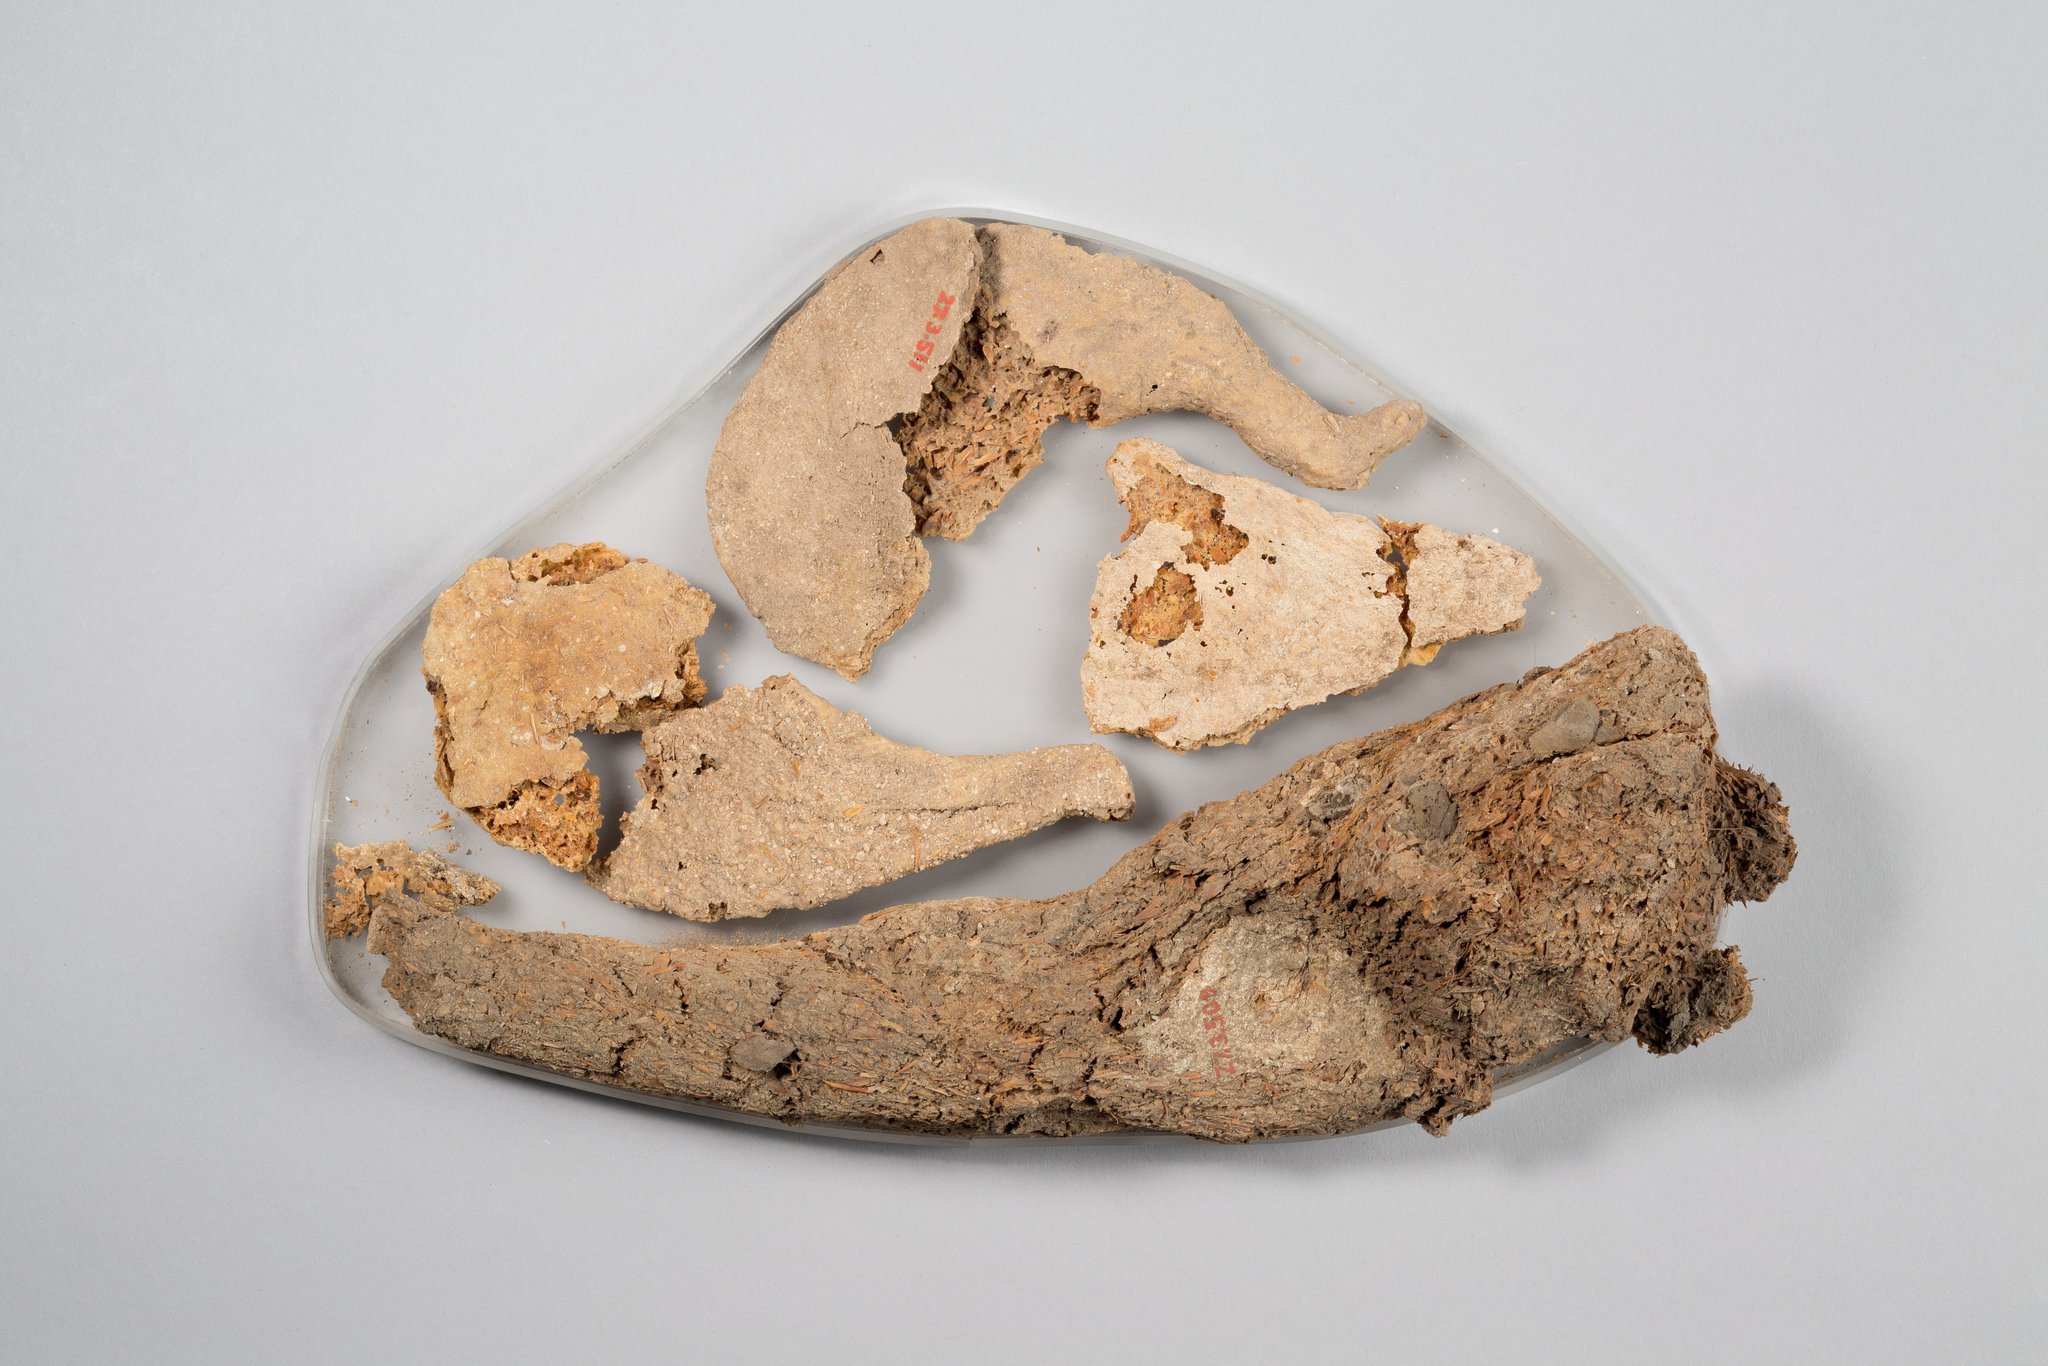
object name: food, bread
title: Bread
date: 1479-1458 BCE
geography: egypt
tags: bread